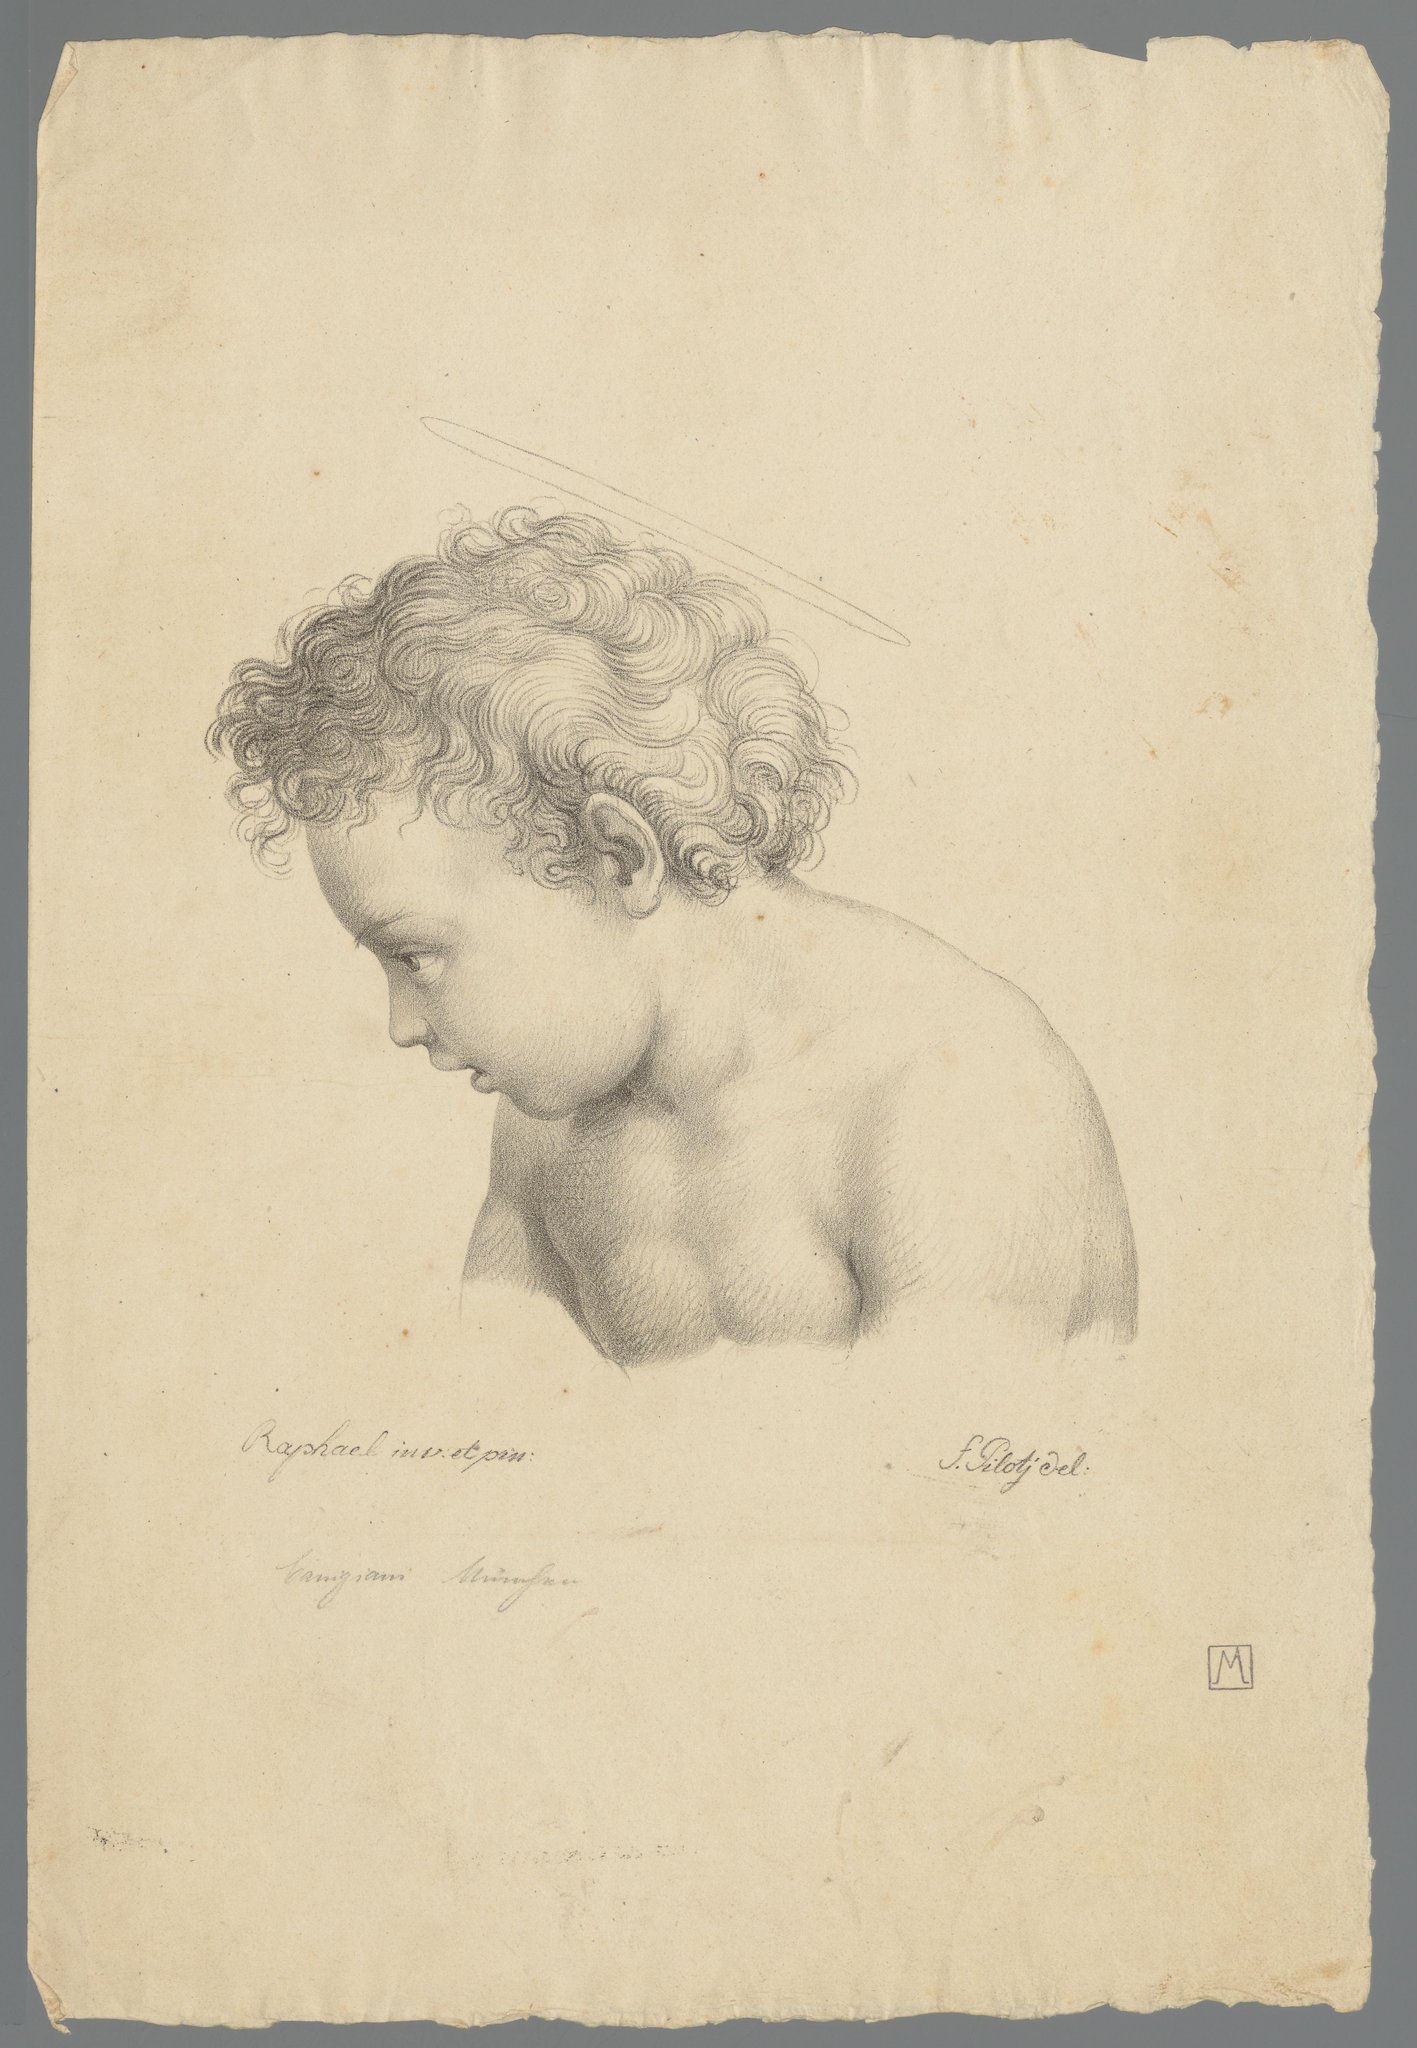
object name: print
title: Christuskind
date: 1820-1876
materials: paper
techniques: lithograph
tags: nimbus, halo ~ radiance emanating from persons or things, christ as child or youth (in general) ~ christian religion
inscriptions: mark: Lugt 1849a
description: Het Christuskind is vervaardigd naar een figuur op de zogenoemde 'De Heilige Familie Canigiani' door Rafaël.